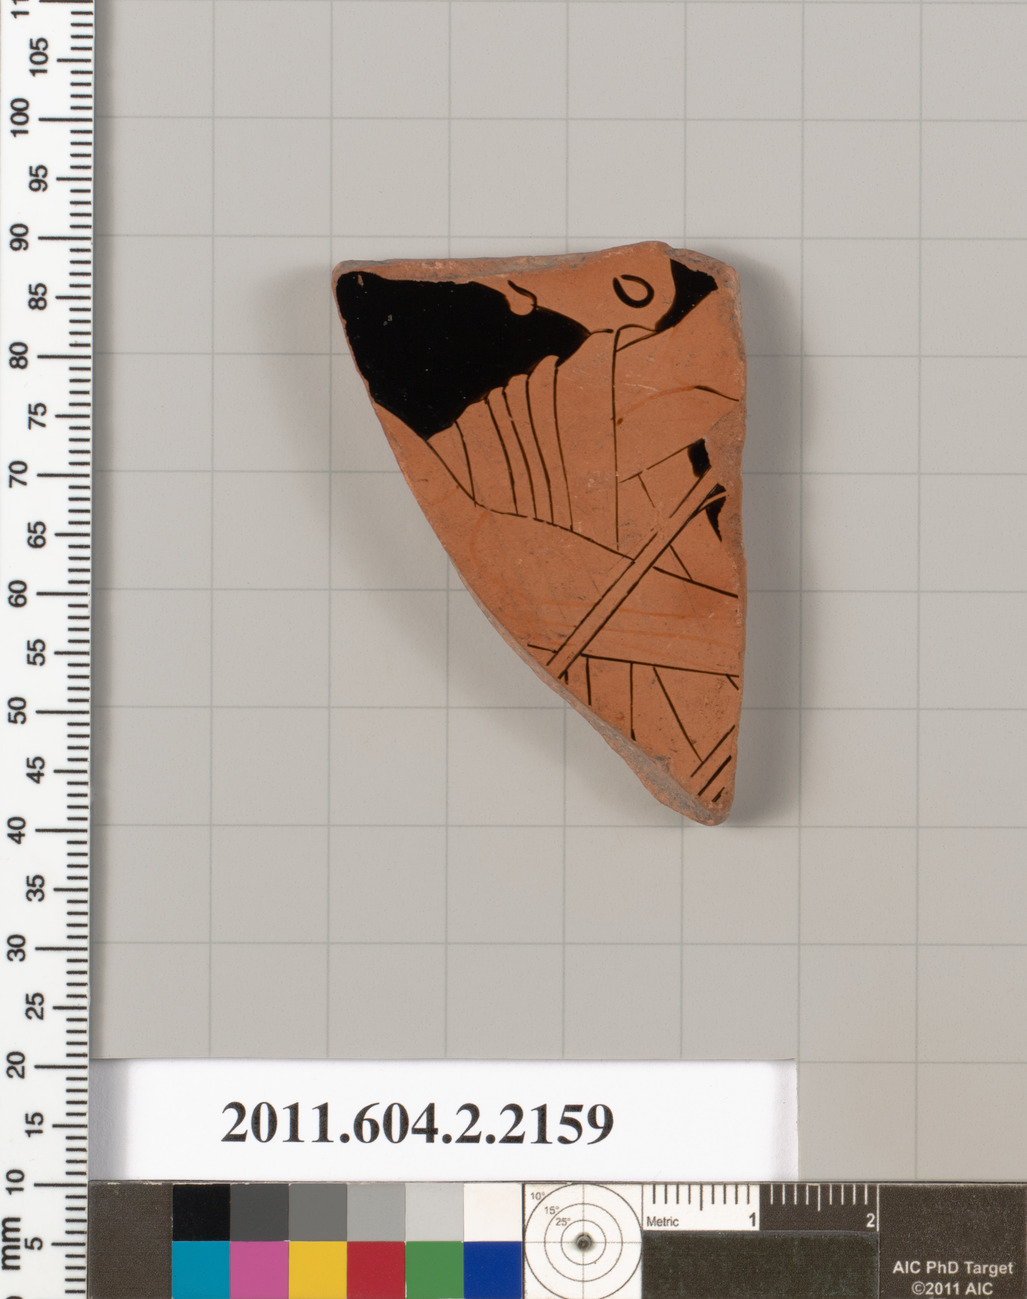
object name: pot fragment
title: Terracotta fragment of a pot; unglazed on the inside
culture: greek, attic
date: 480-470 BCE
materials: terracotta